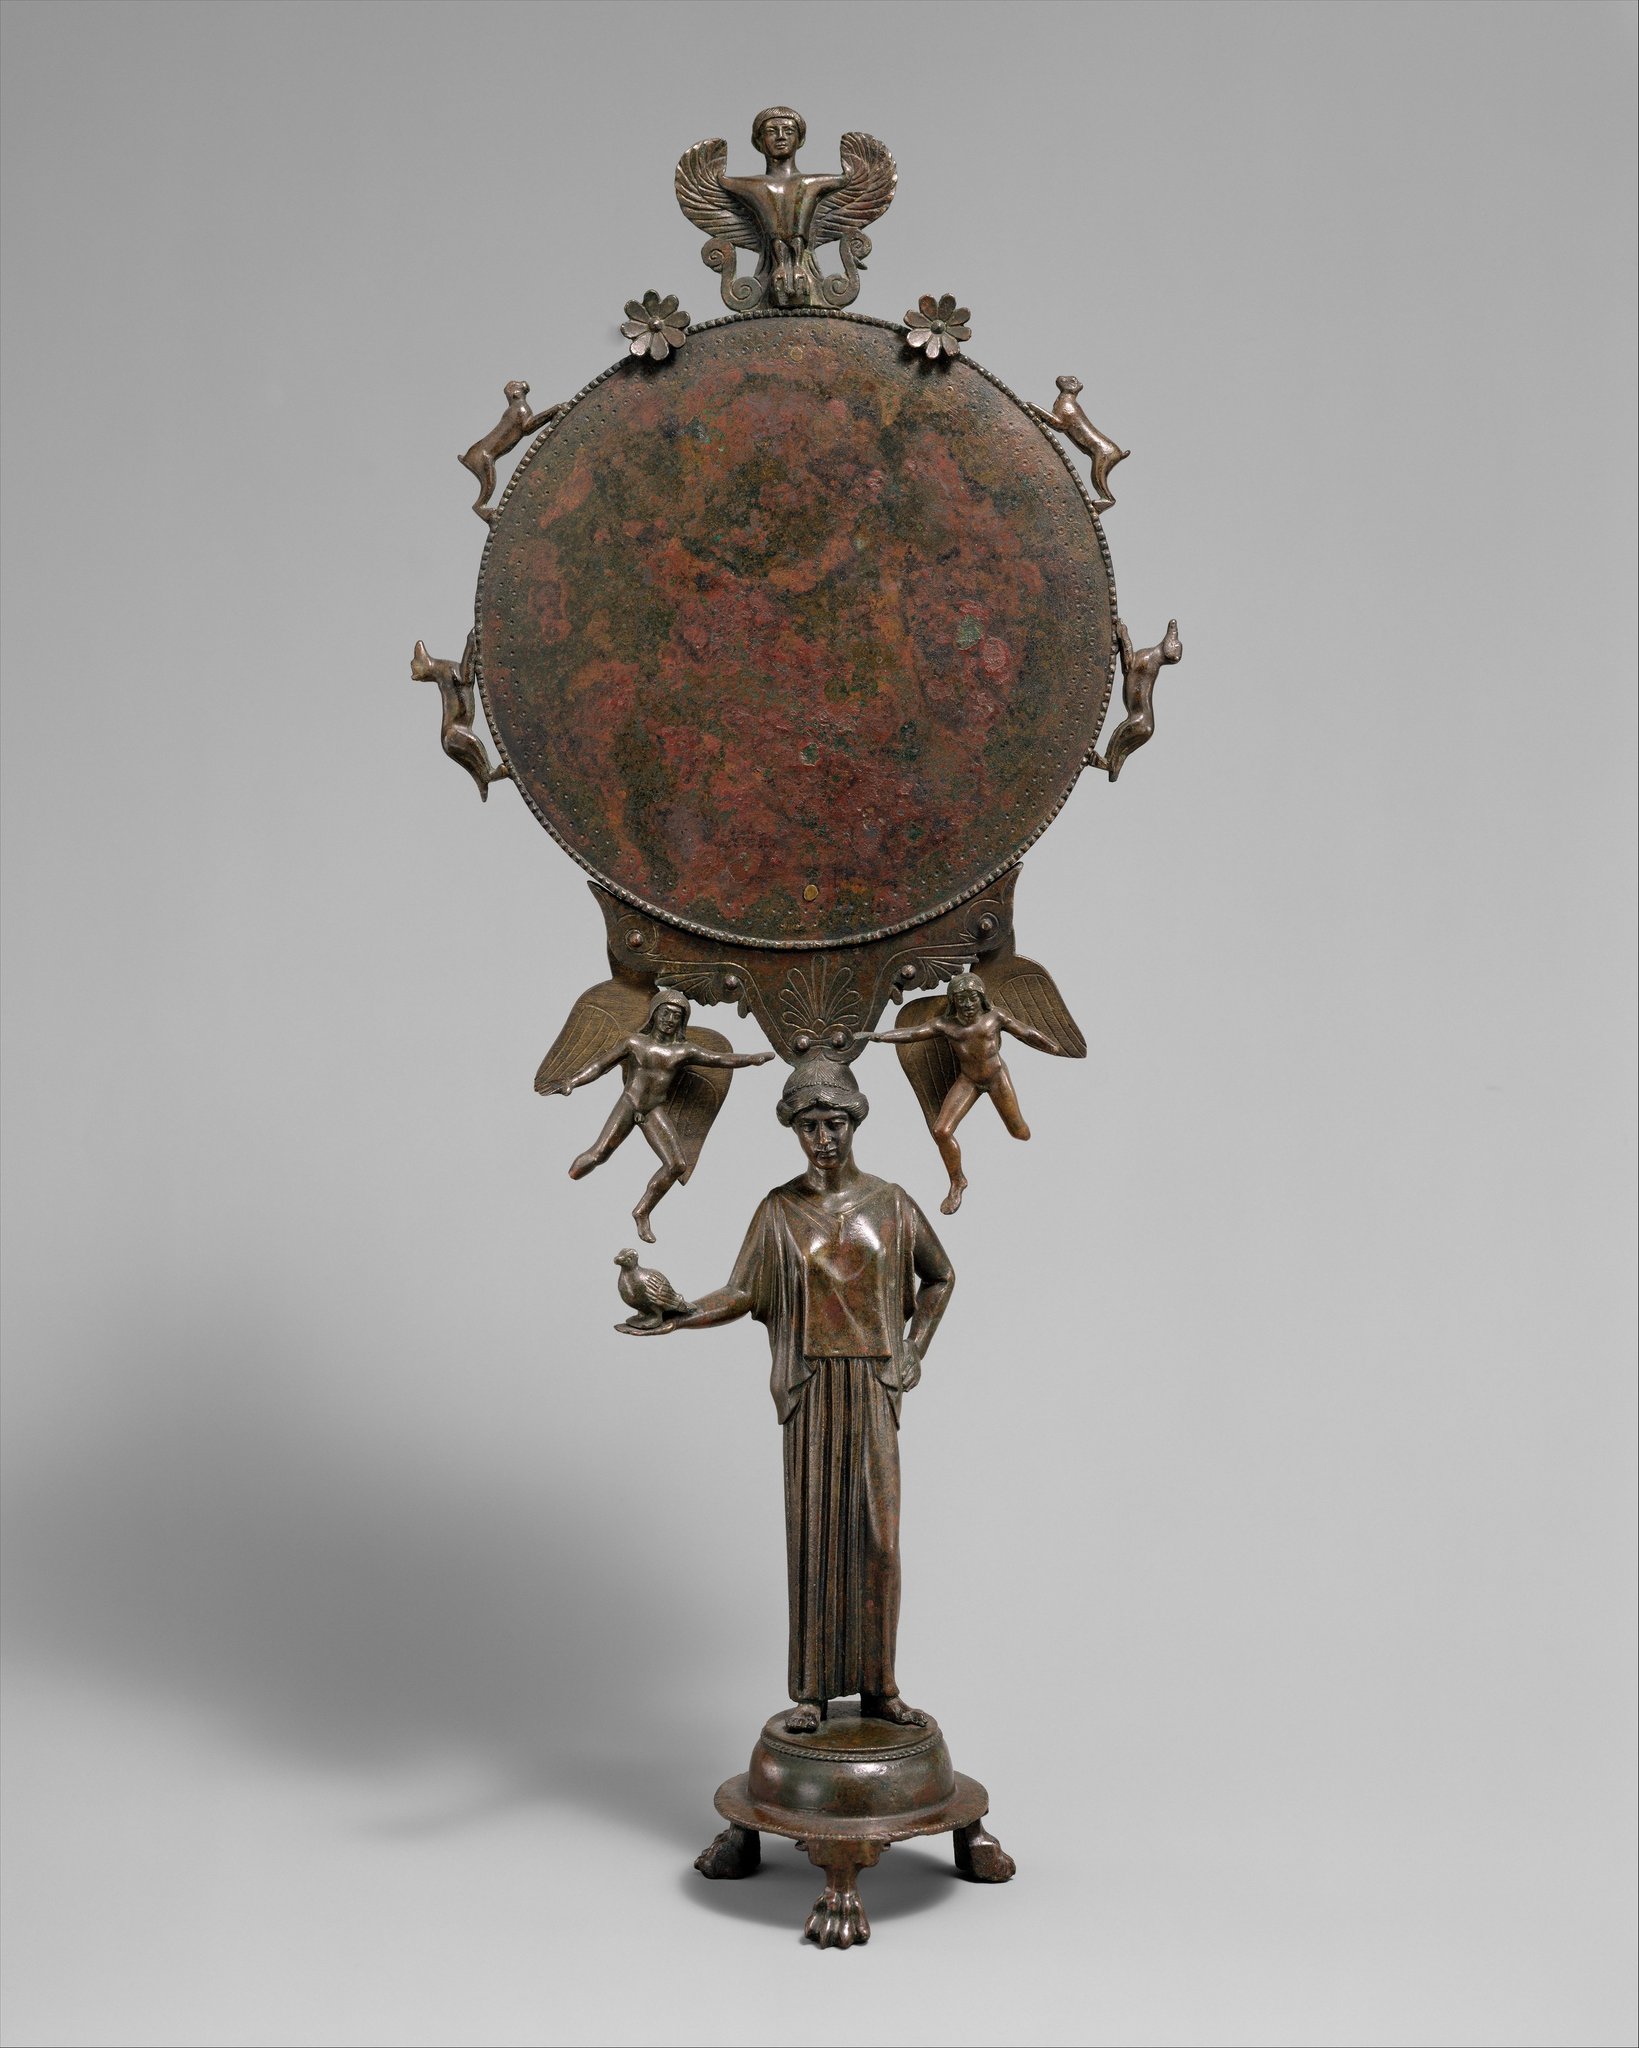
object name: mirror with a support in the form of a draped woman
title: Bronze mirror with a support in the form of a draped woman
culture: greek, argive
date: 467-435 BCE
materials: bronze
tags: birds,women,dogs